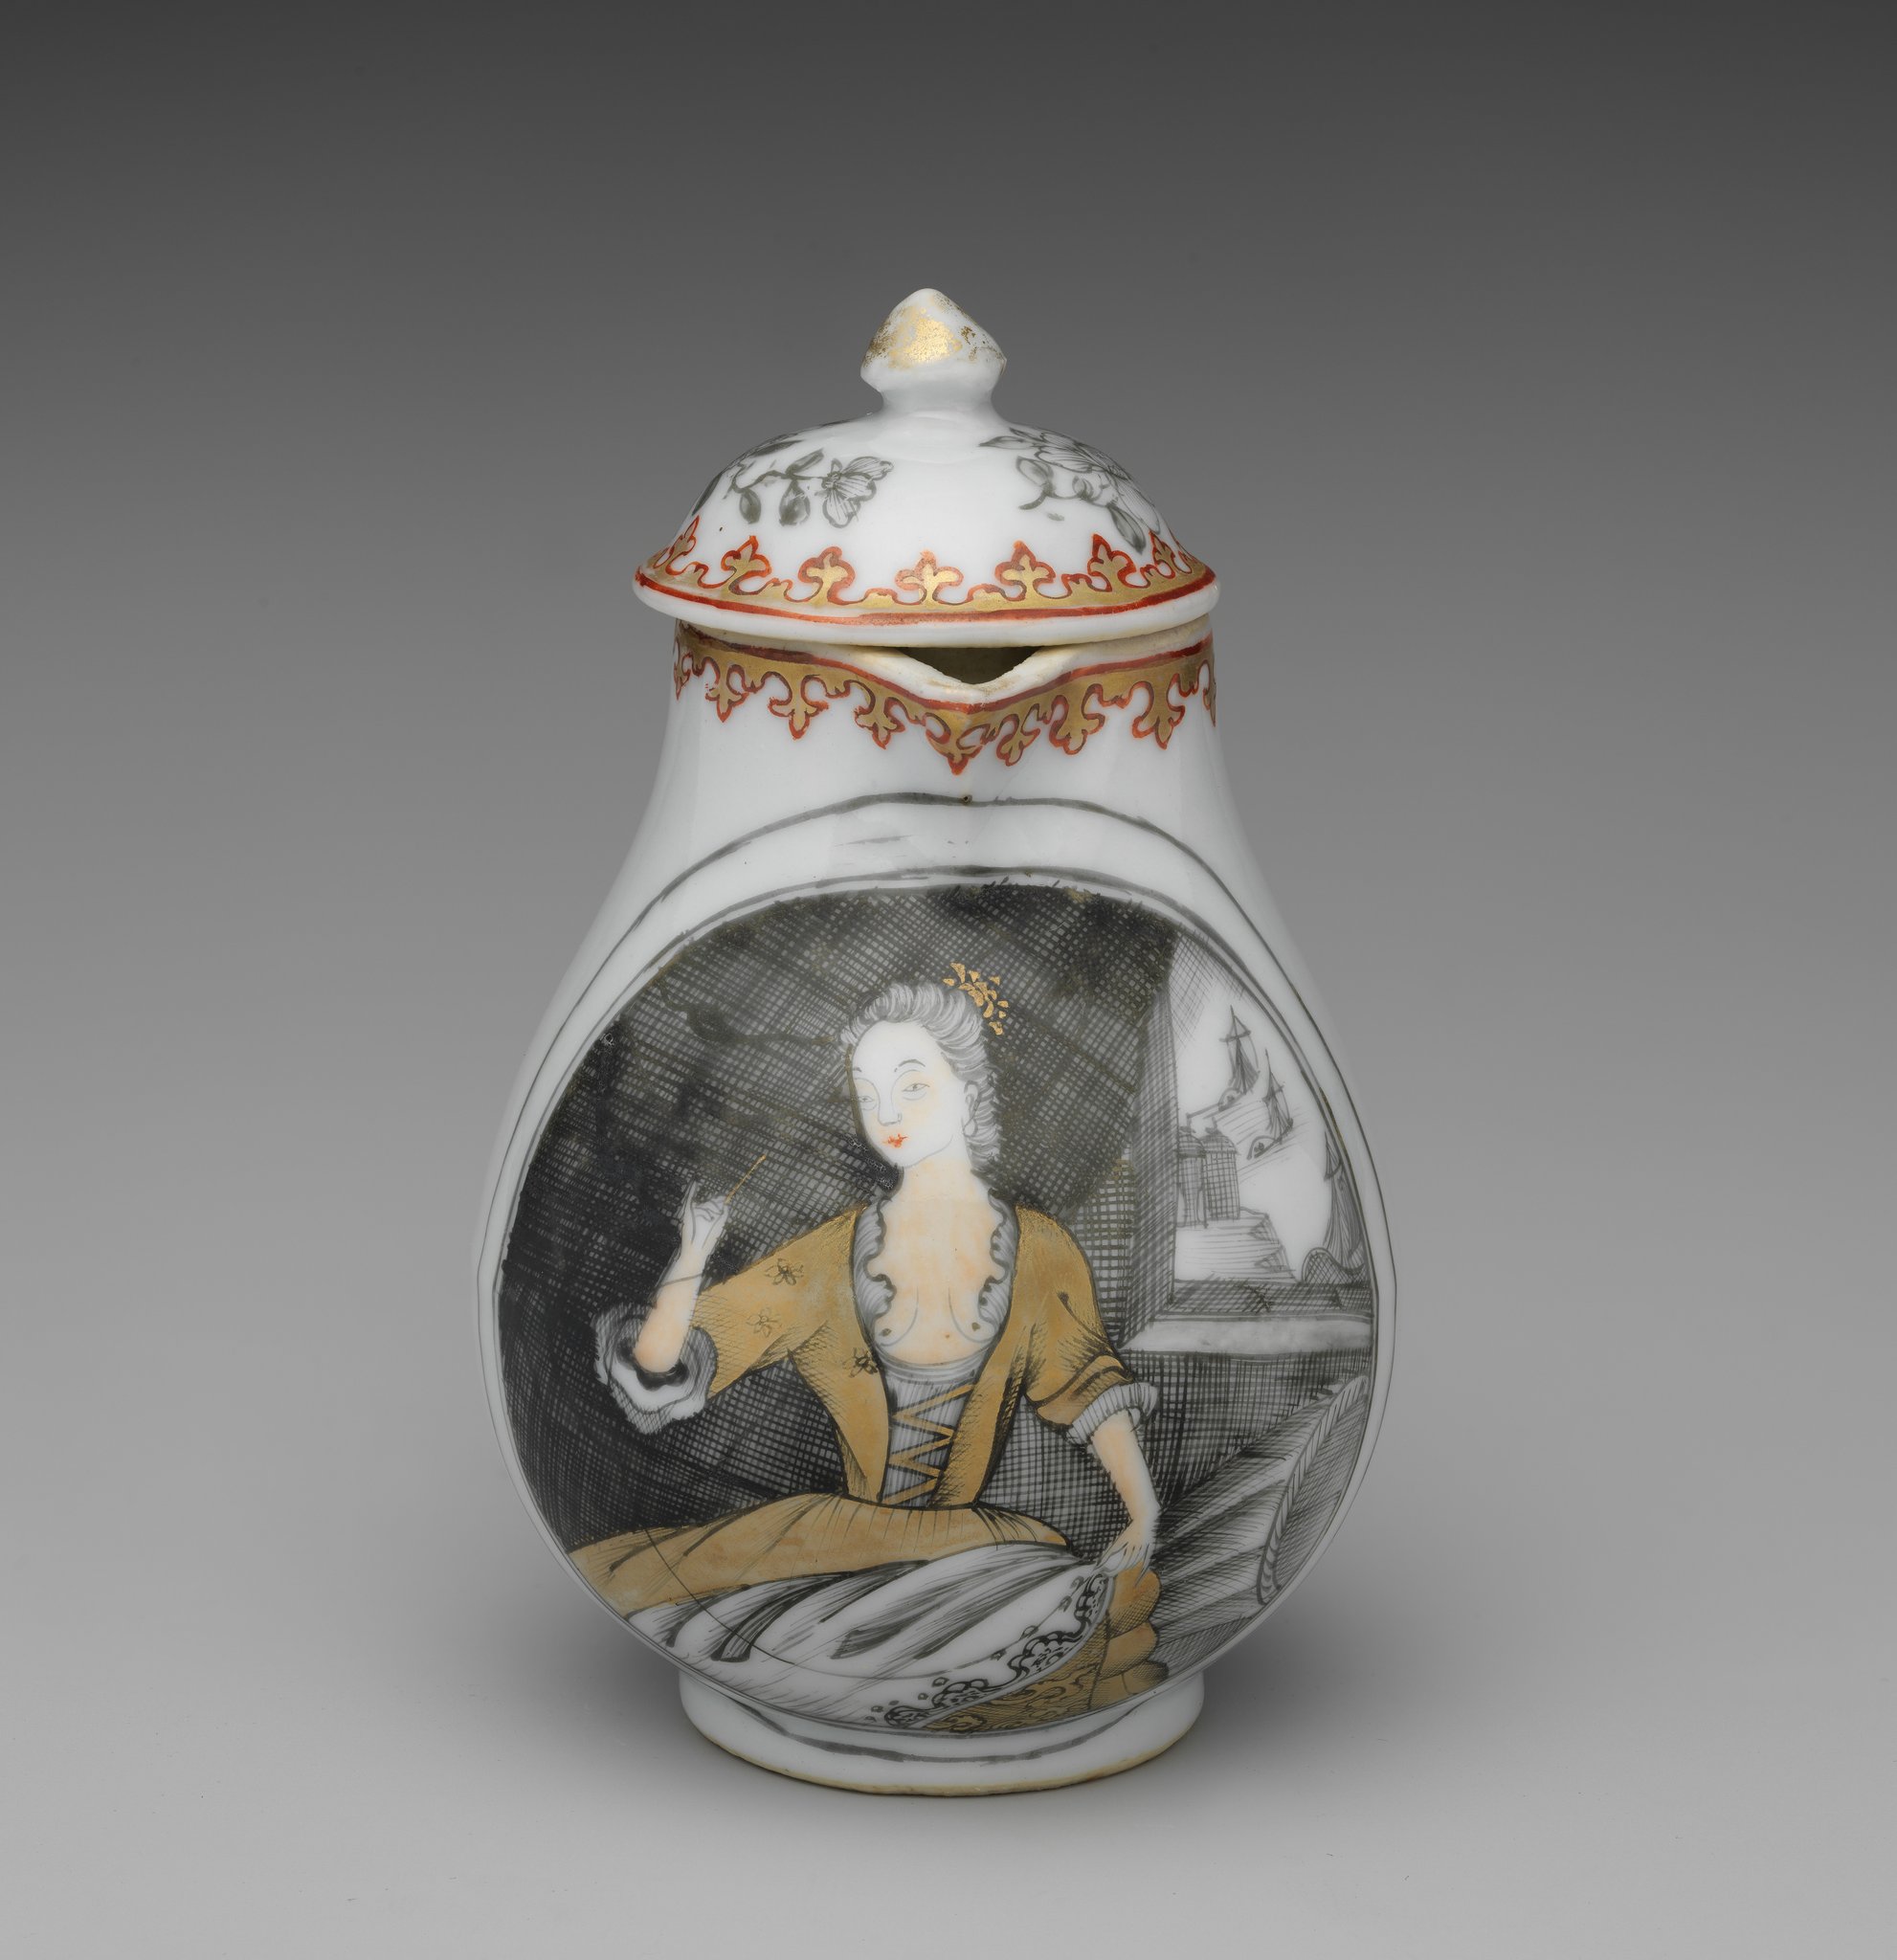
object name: creamer with cover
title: Creamer with cover (part of a service)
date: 1750-1770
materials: hard paste porcelain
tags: women,needlework,sewing